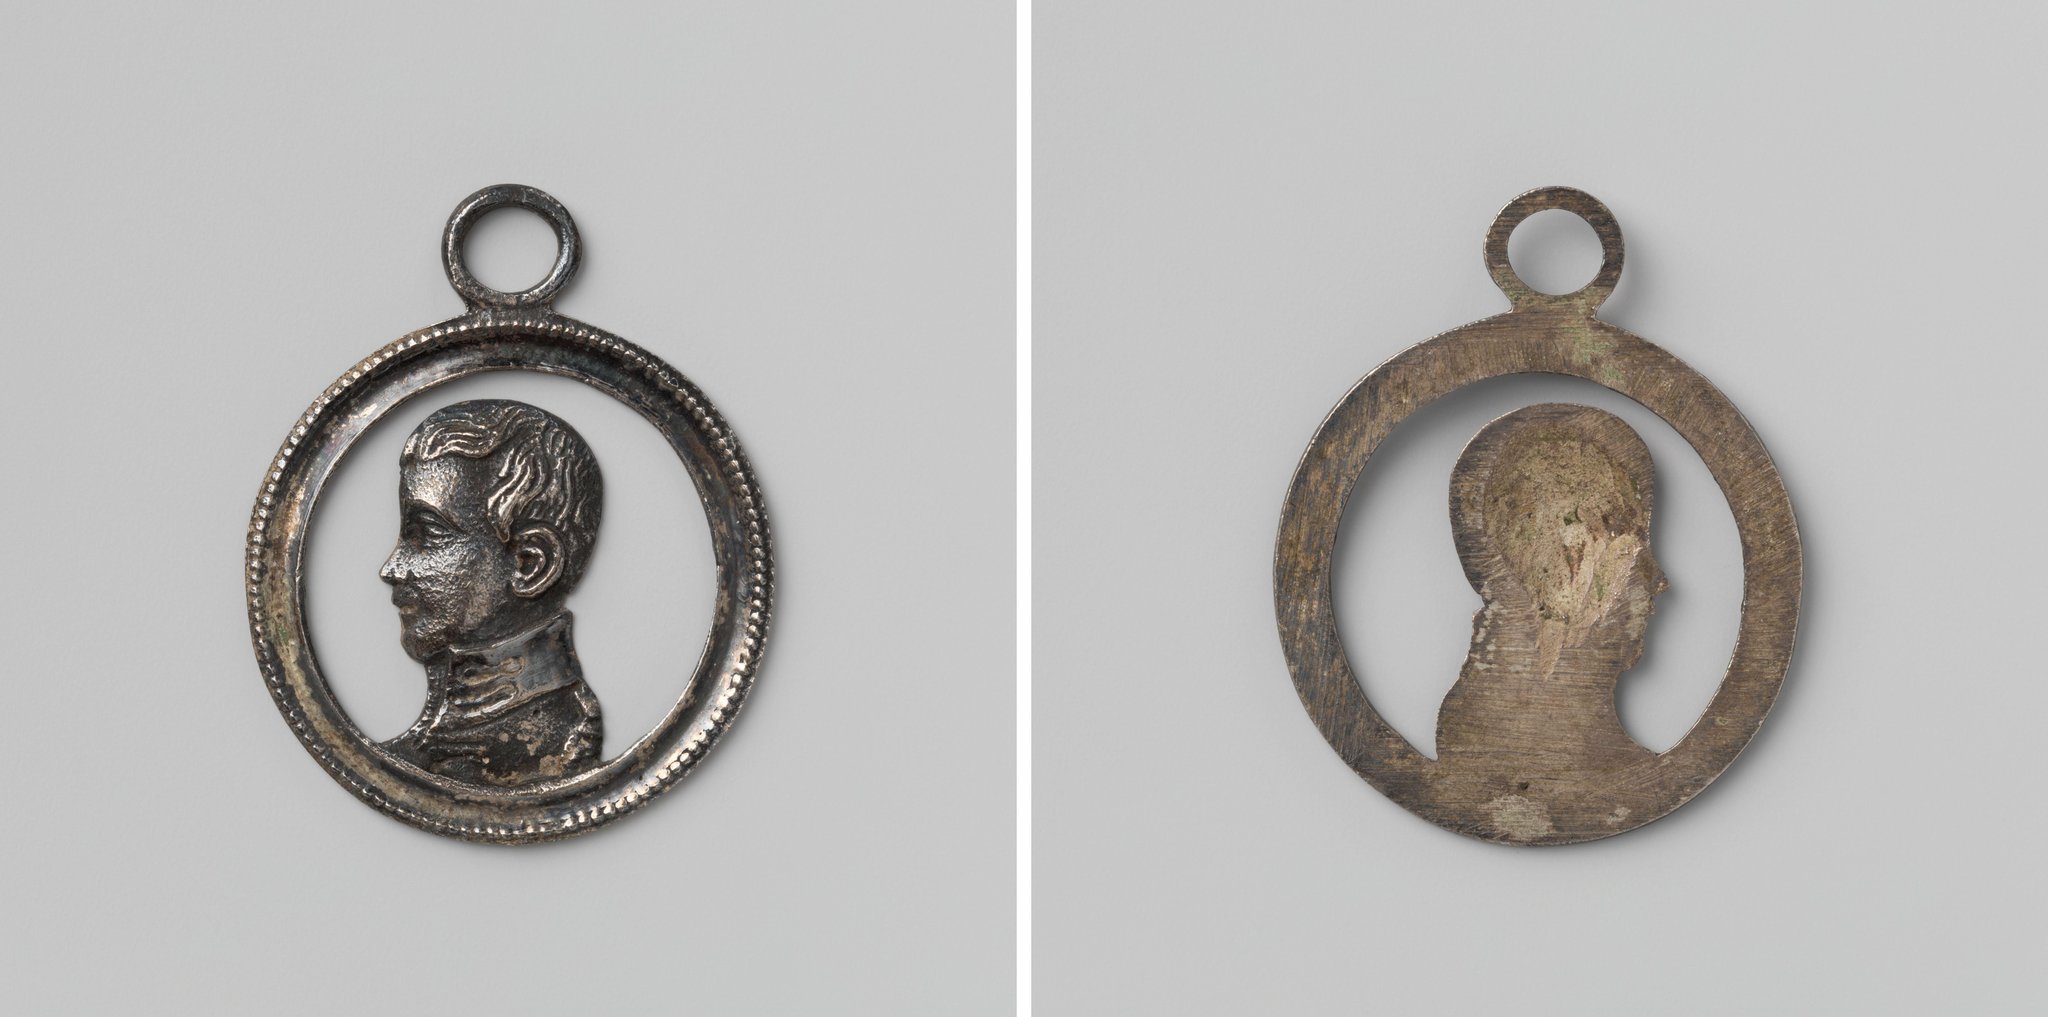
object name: insignia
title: Willem Frederik, prins van Oranje-Nassau, souverein vorst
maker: Anonymous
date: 1813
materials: silver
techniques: embroidery, striking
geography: netherlands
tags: the hague, berlin, william i of the netherlands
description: Eenzijdig zilveren opengewerkt draagteken, met parelrand aan draagoog. Voorzijde: borststuk man. Keerzijde: blanco